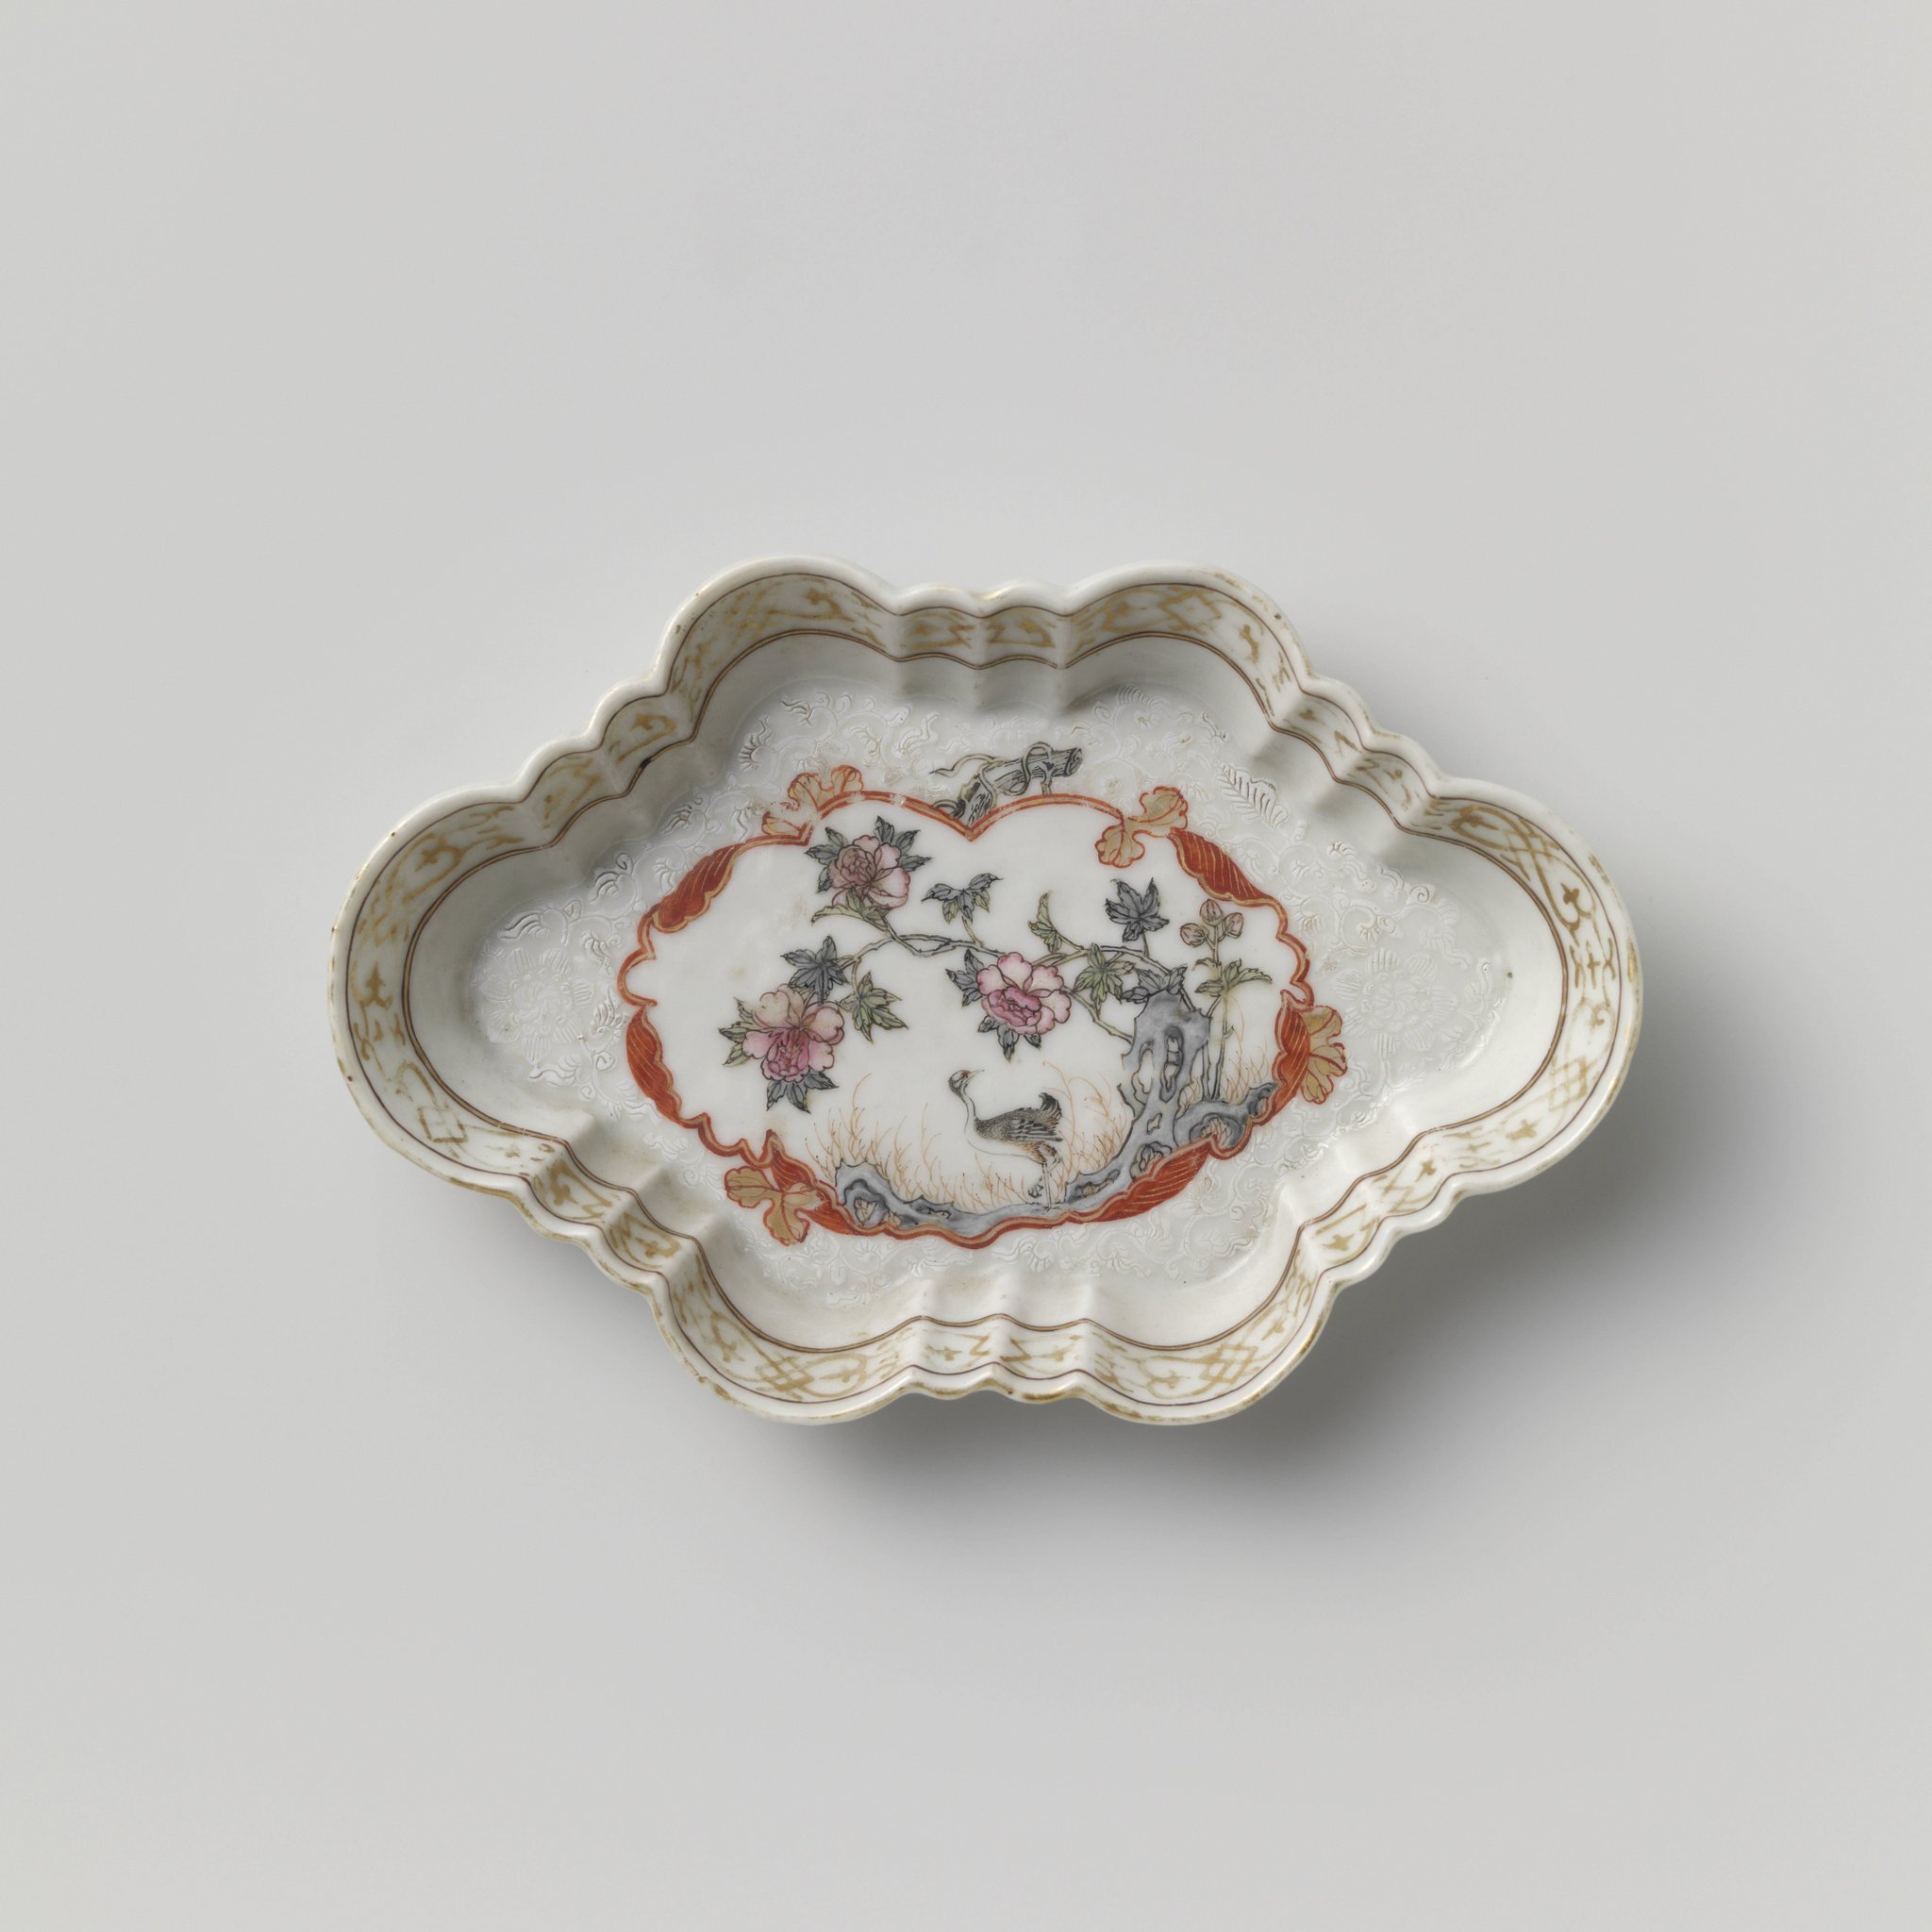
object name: pattipan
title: Spoon tray with a crane near a peony plant and rock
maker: Anonymous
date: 1725-1749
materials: glaze, gold, paint, porcelain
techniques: firing, forming, gilding, vitrification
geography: china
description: Gedecoreerd in emails, goud en bianco sopra bianco met vogels en bloeiende planten.